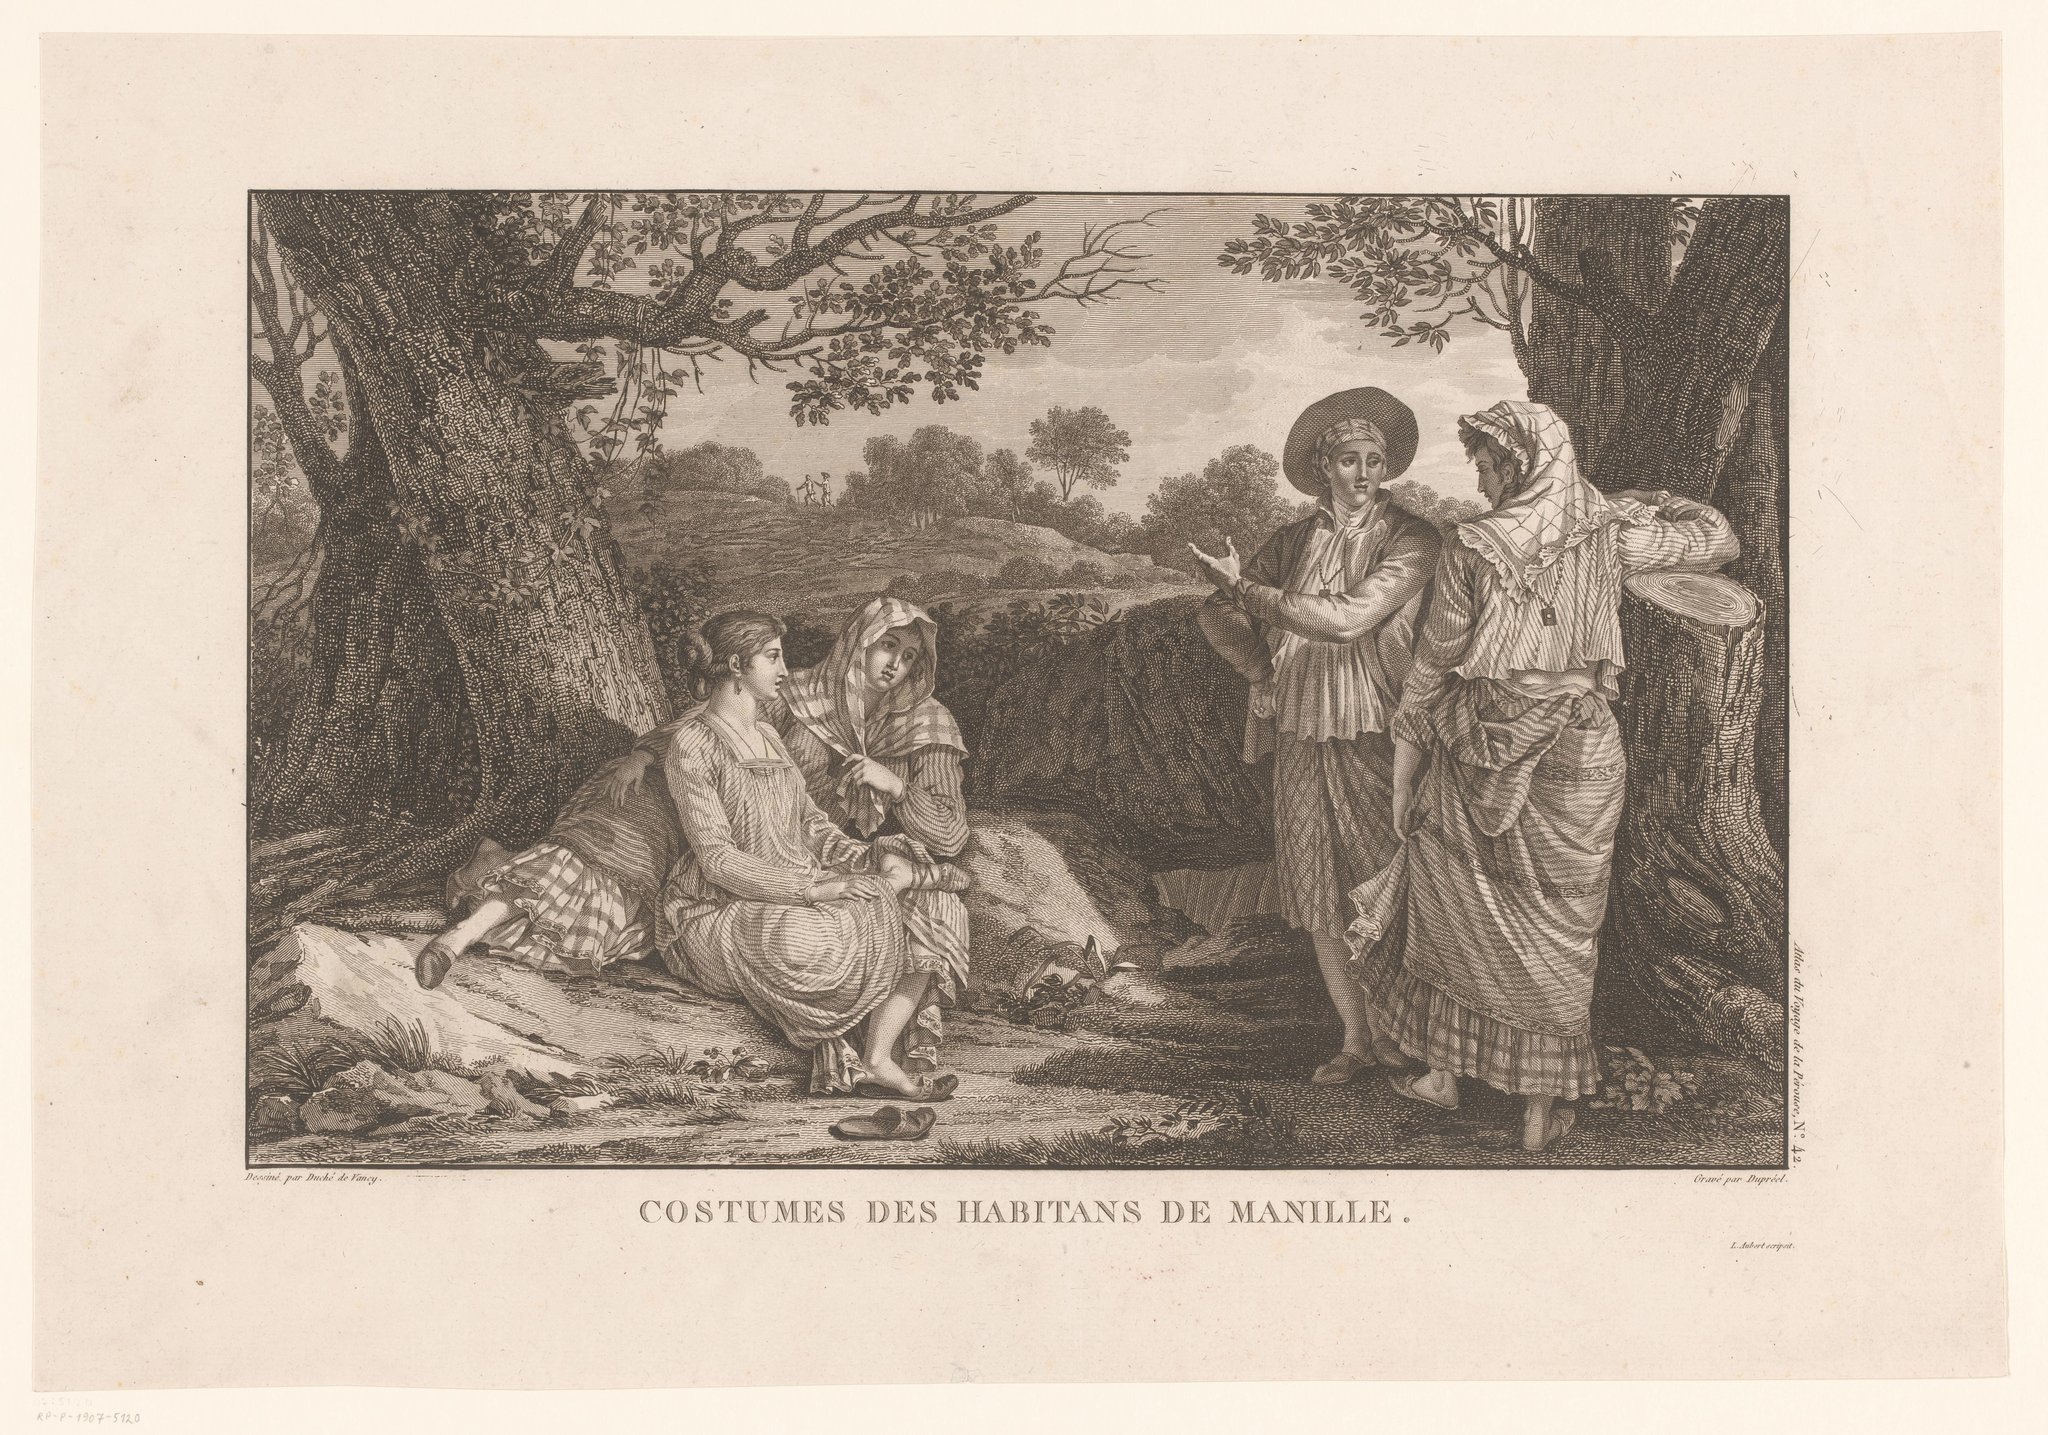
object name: print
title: Landschap met figuren in traditionele klederdracht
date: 1797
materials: paper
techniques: engraving, etching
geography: paris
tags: landscapes, folk costume, regional costume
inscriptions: collector's mark: Lugt 2228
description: Prent uit: Milet-Mureau, Louis-Antoine Destouff. Atlas du voyage de La Pérouse. Parijs: Imprimerie de la République, 1797.